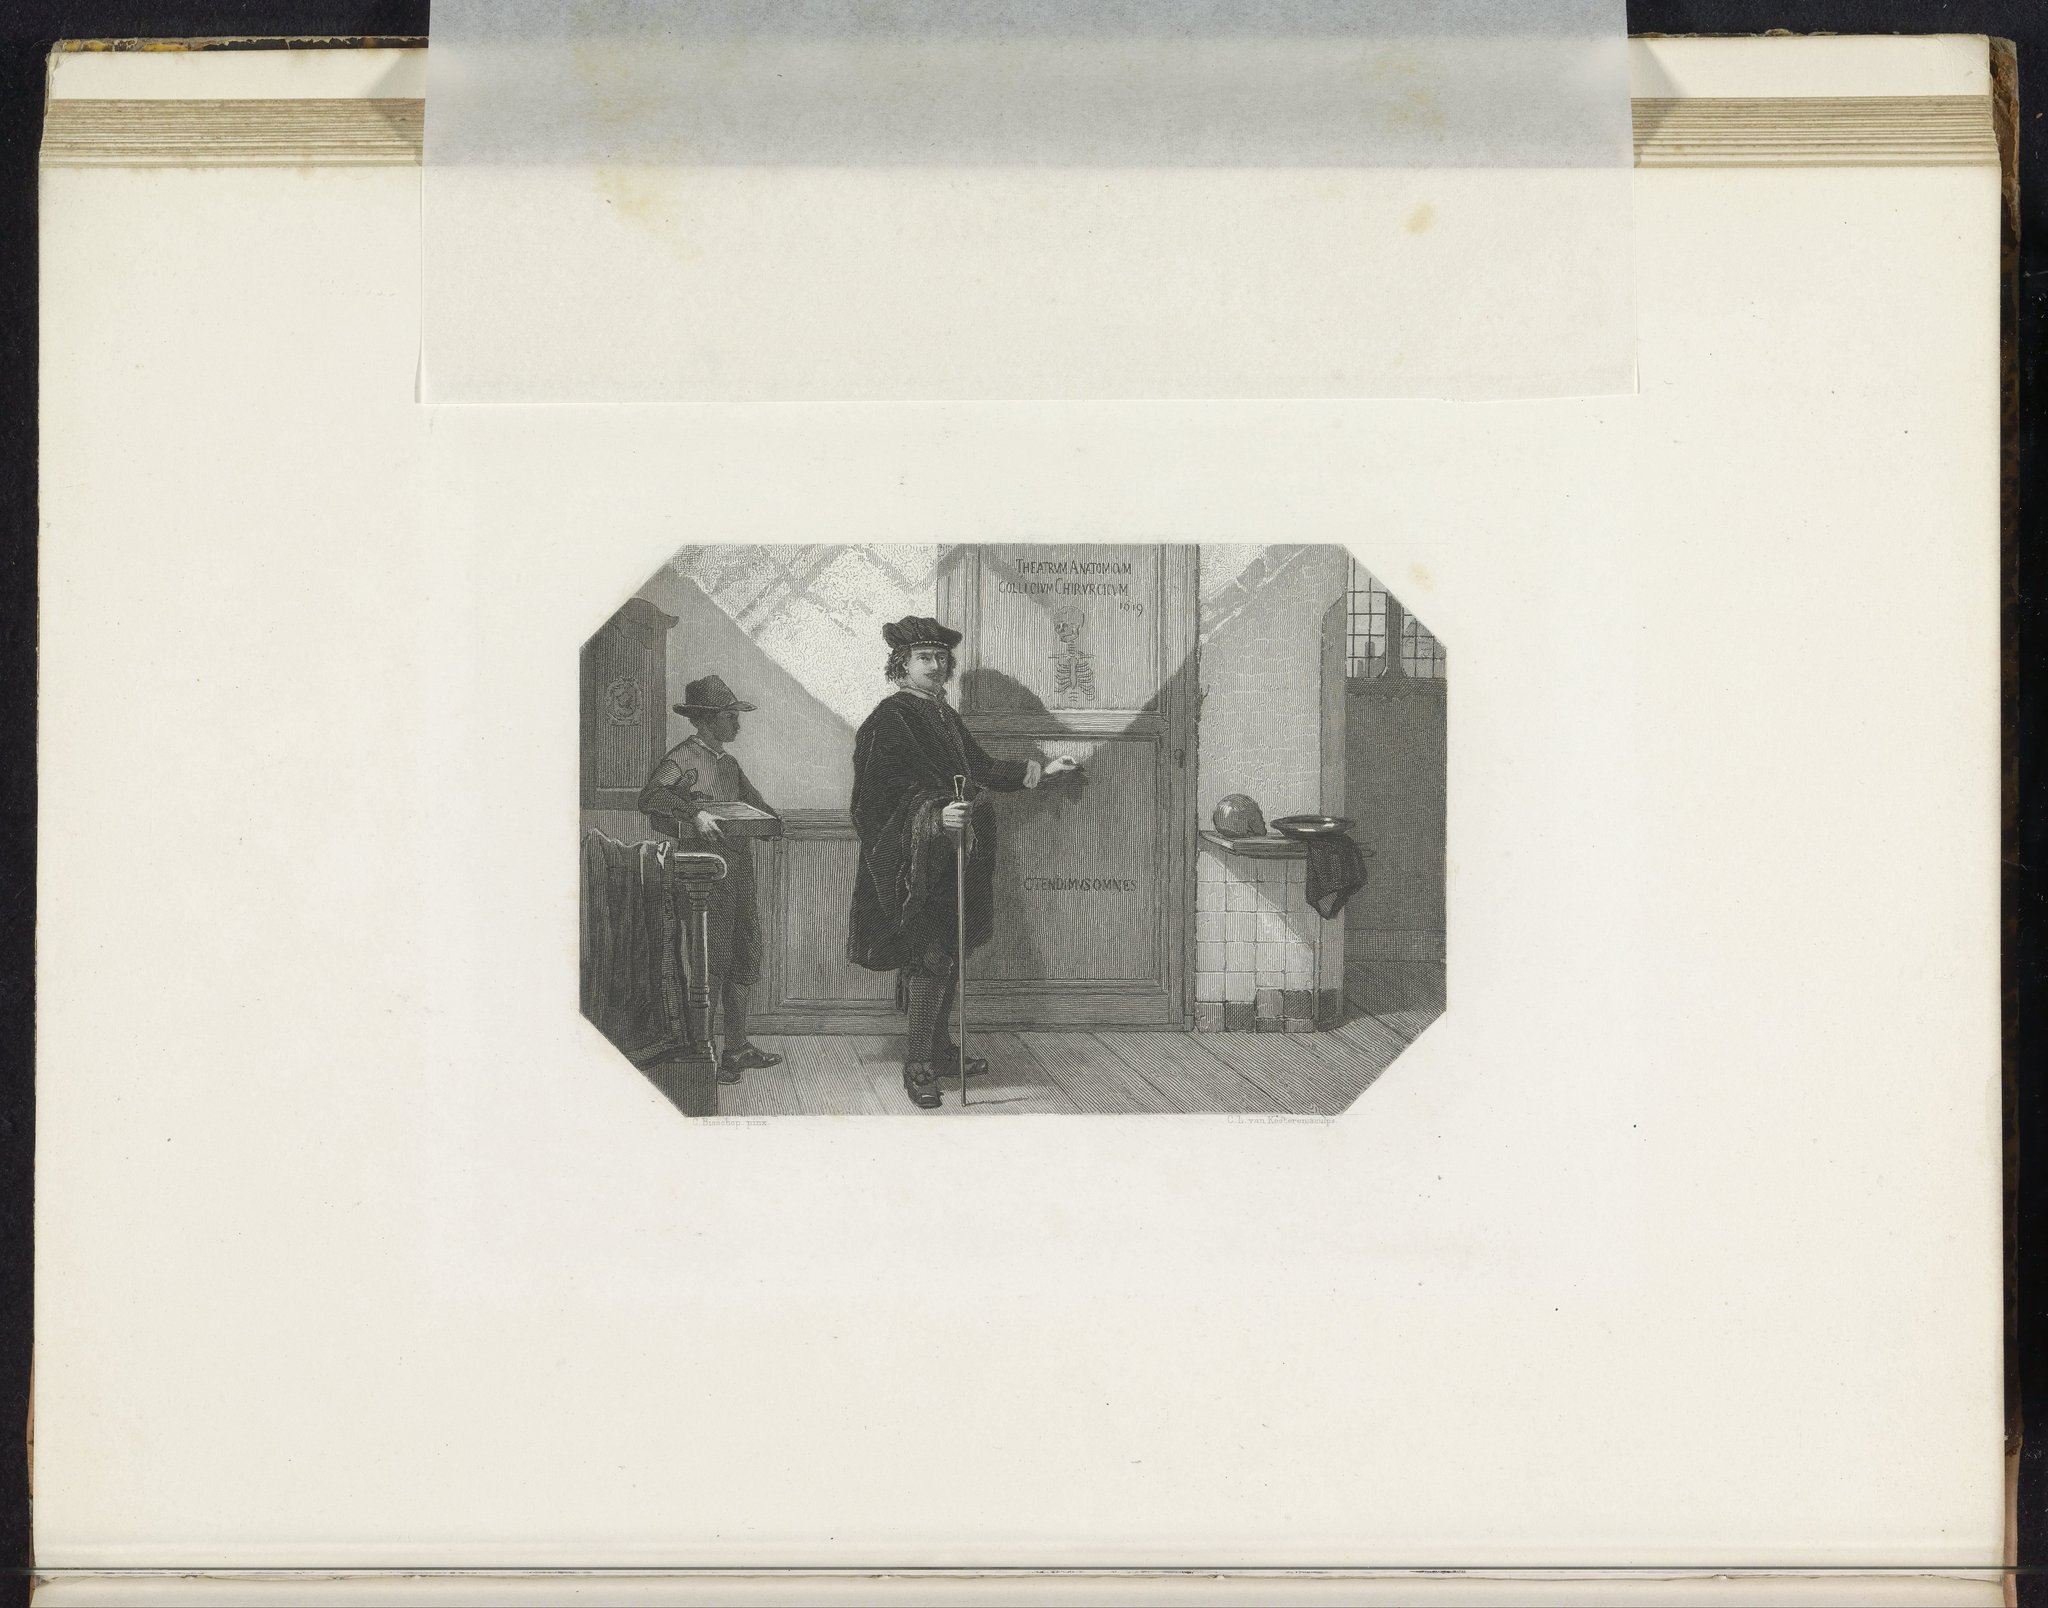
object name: print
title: Rembrandt bij de deur naar het anatomisch theater, ca. 1630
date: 1865-1870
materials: paper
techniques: engraving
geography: netherlands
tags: leiden, print maker, draughtsman, rembrandt van rijn, painting (including book-illumination, miniature-painting), amsterdam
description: De schilder Rembrandt staande bij de deur naar het anatomisch theater, ca. 1630. Onderdeel van de groep staalgravures naar de schilderijen van de Historische Galerij der Maatschappij Arti et Amicitiae.